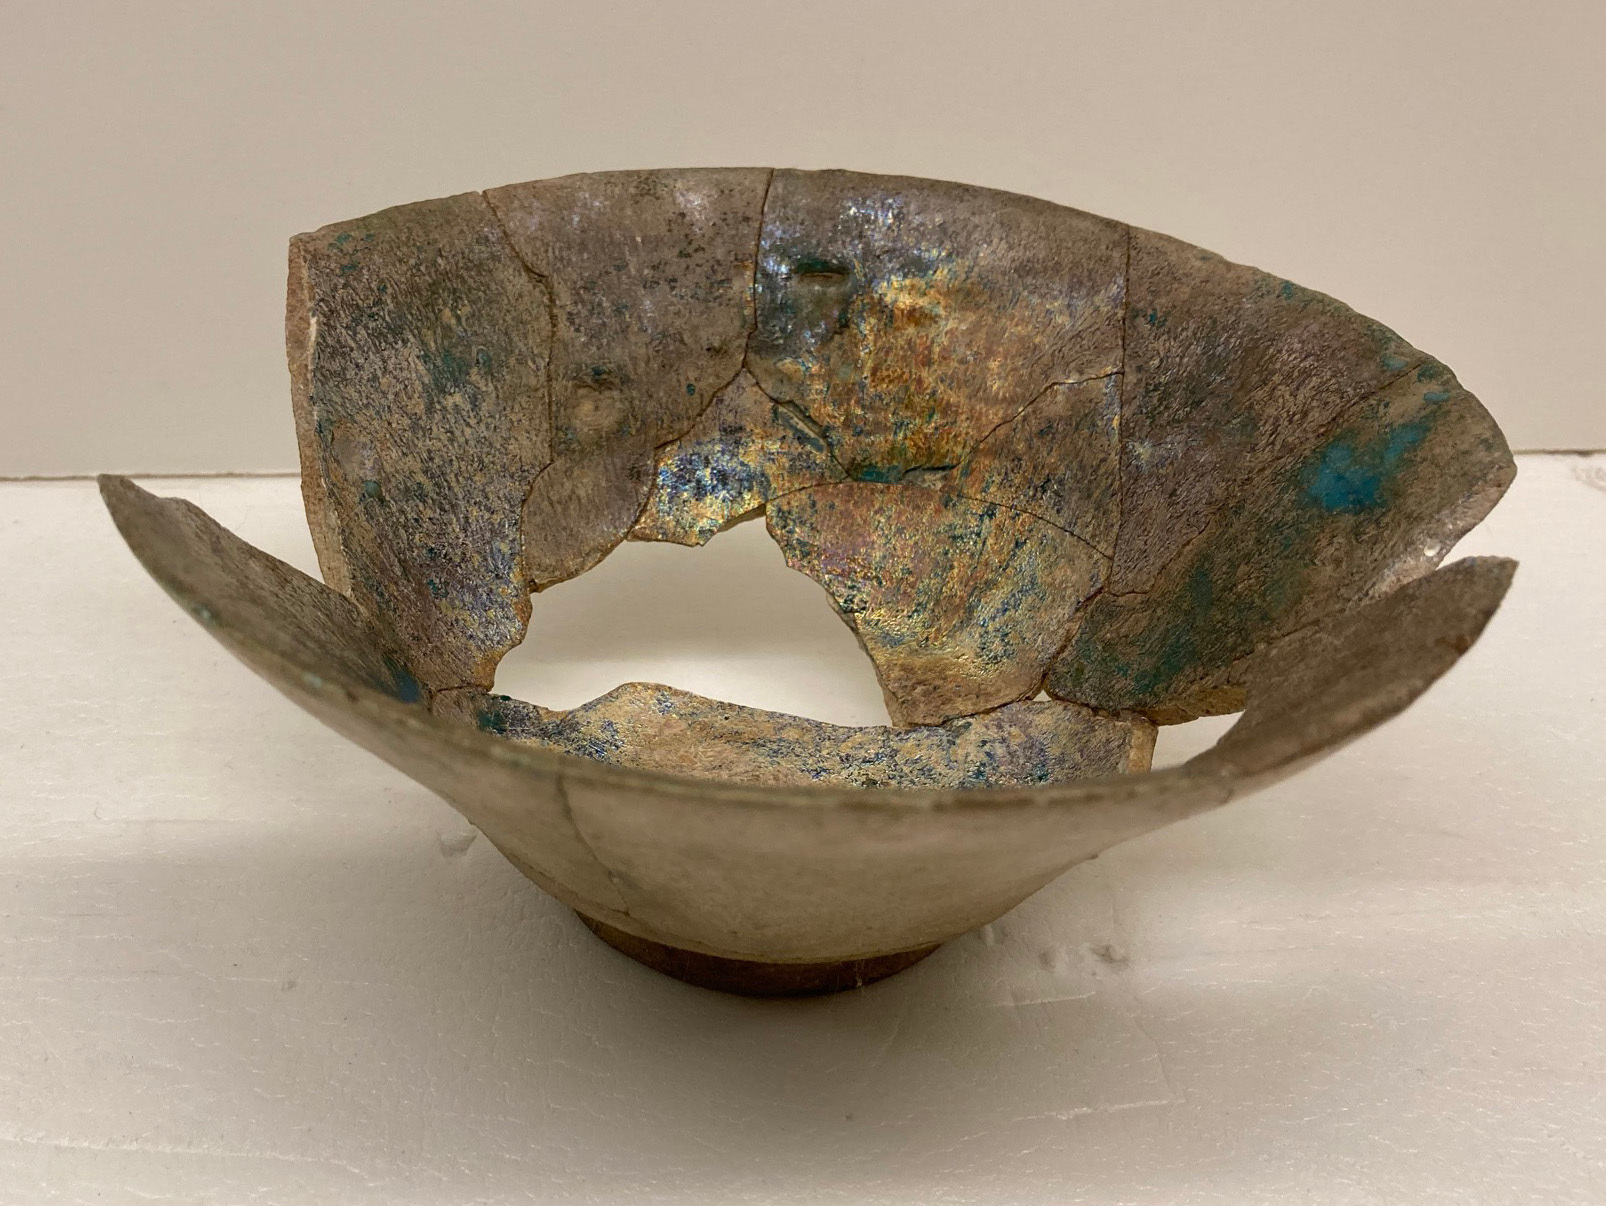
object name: bowl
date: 801-1000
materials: earthenware, glaze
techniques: incising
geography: iran